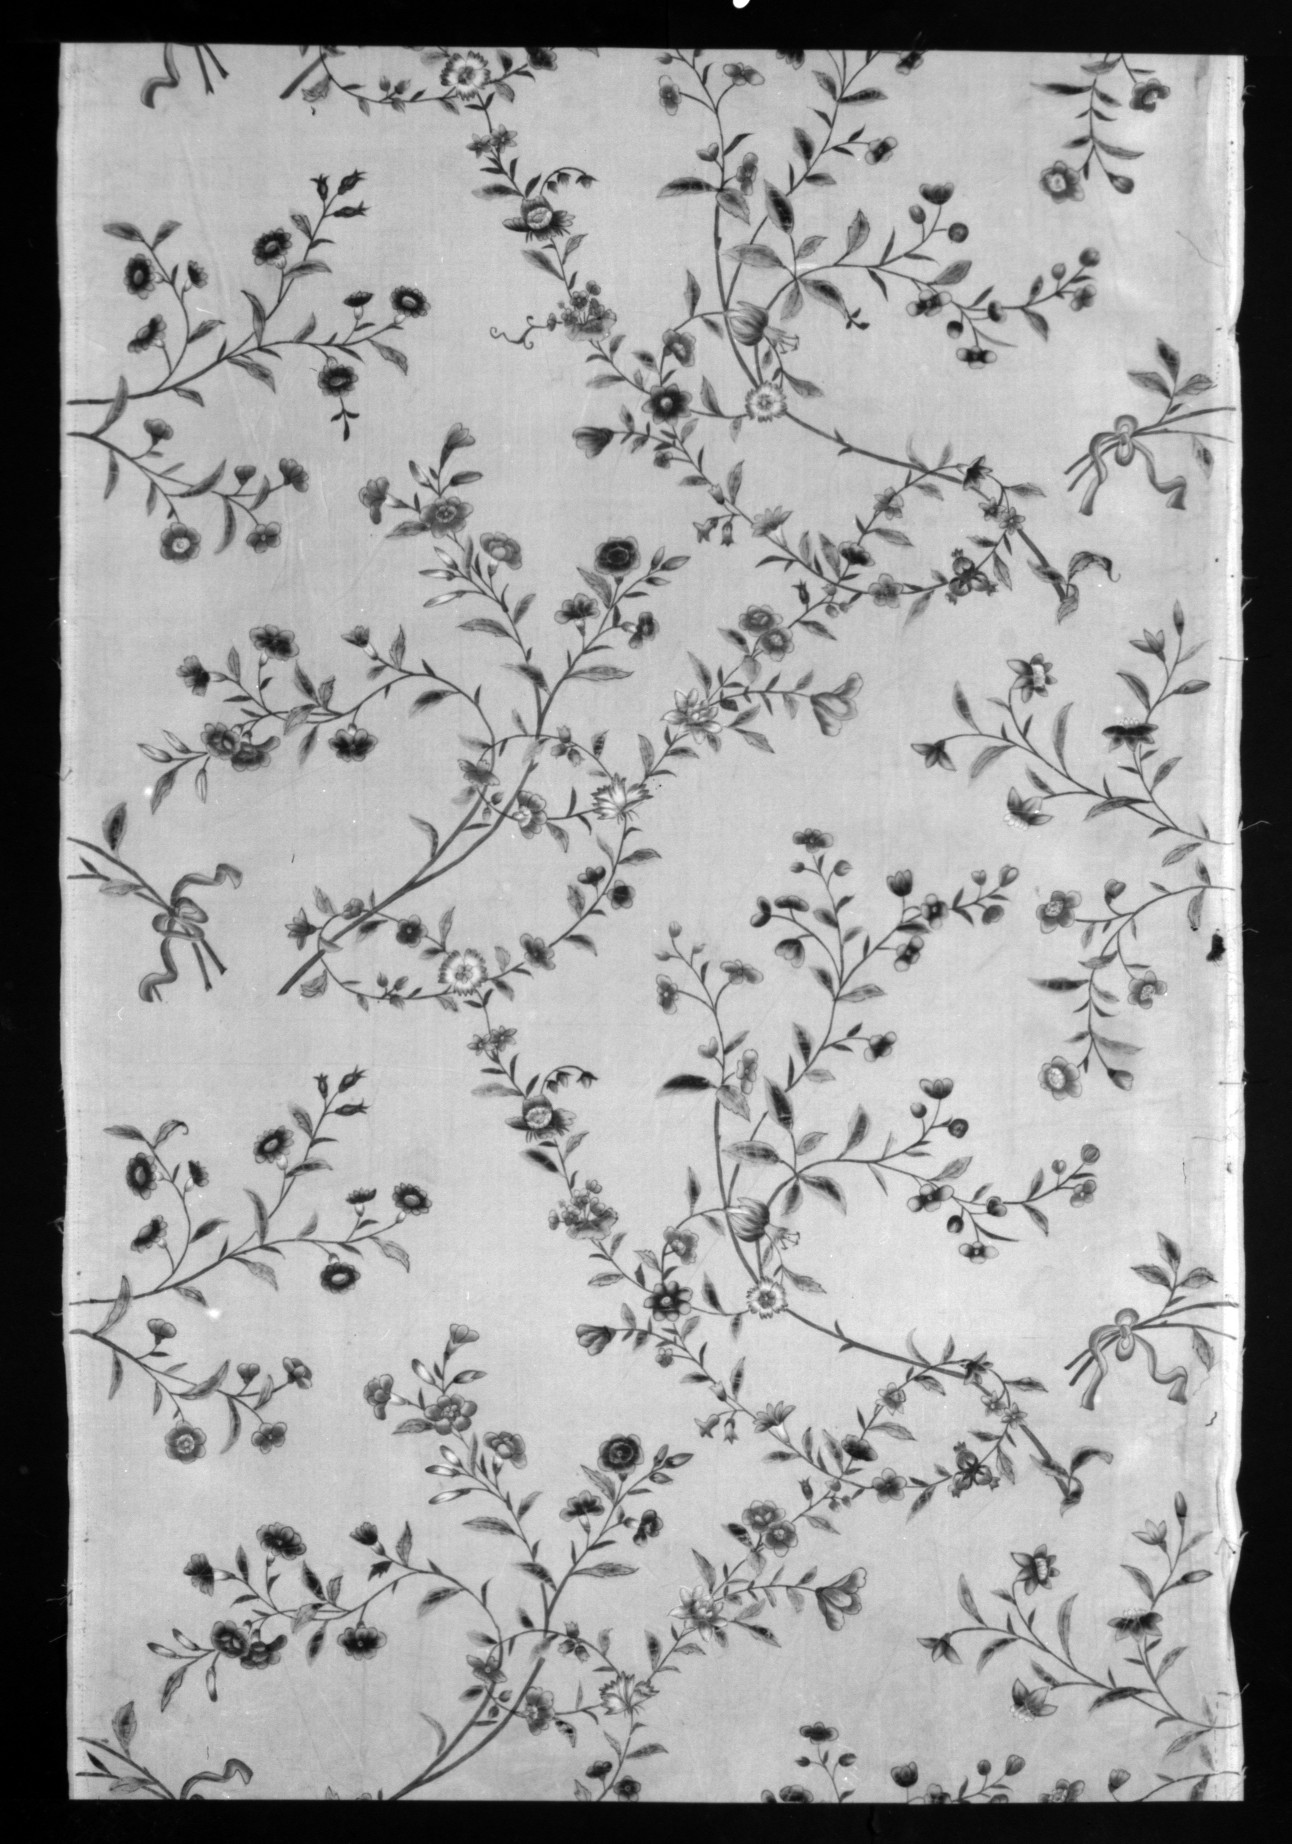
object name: panel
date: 1750-1760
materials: silk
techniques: painting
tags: flowers